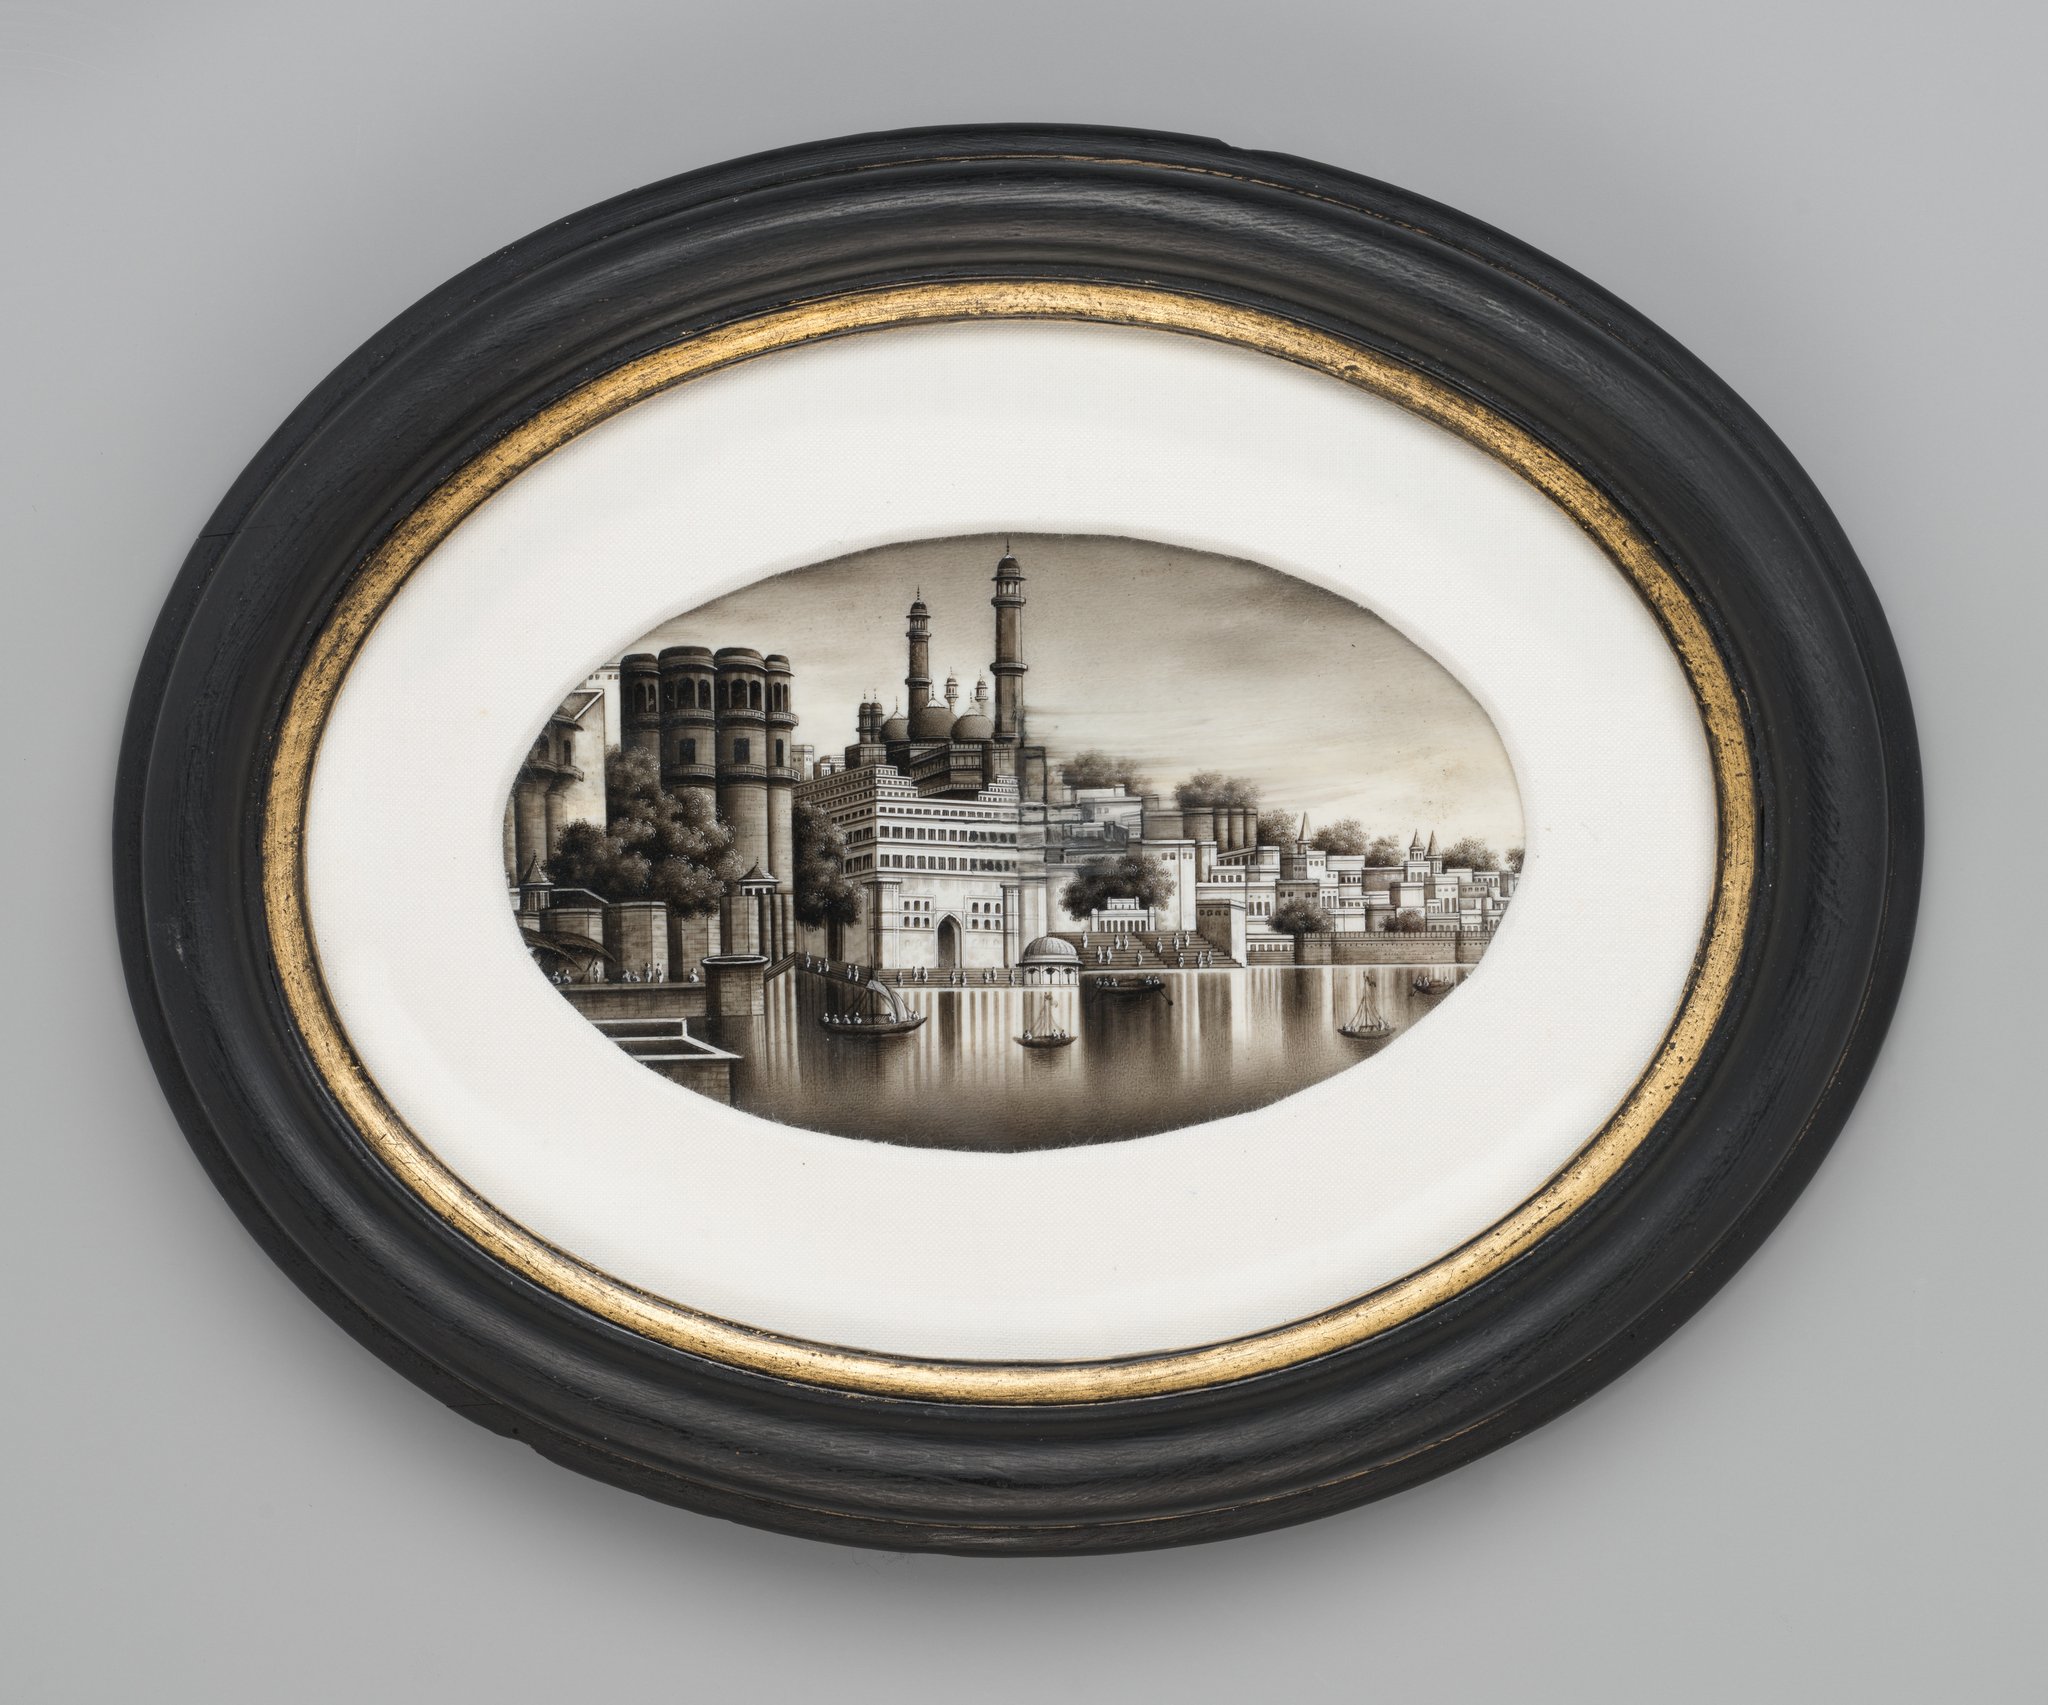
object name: painting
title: Painting of Alamgir Mosque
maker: Anonymous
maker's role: artist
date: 1801-1900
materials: ink, ivory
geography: india